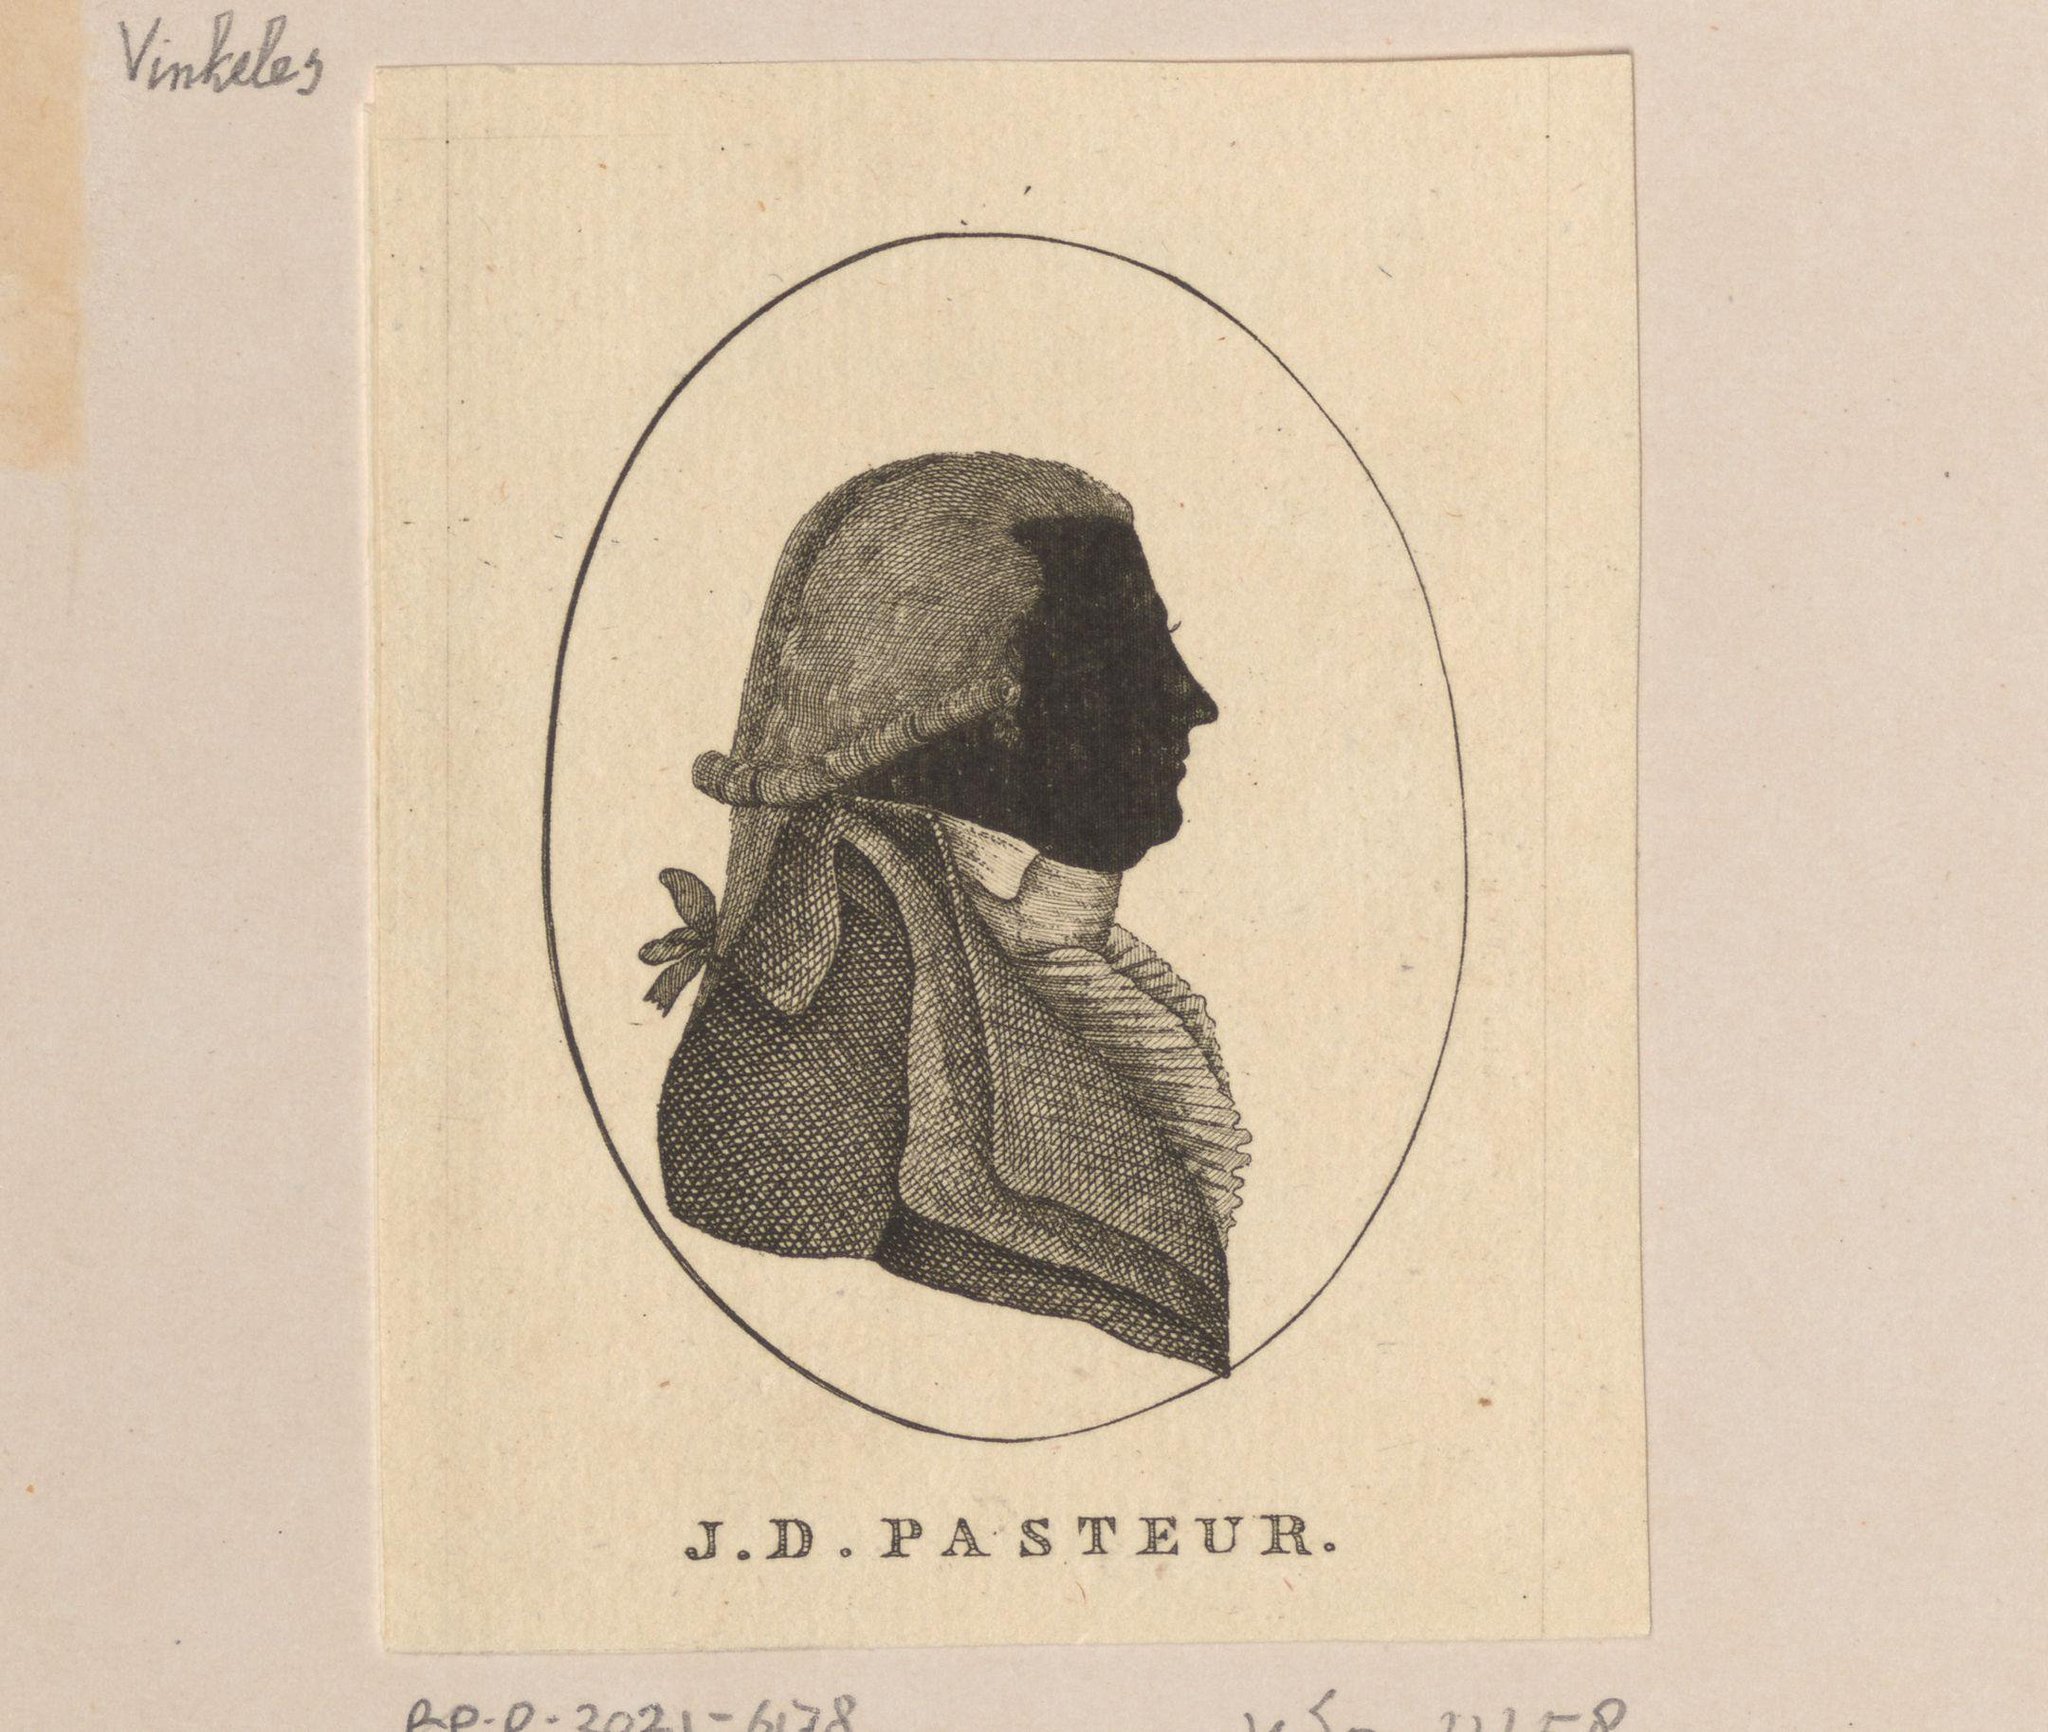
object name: print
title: Portret van Jan David Pasteur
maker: Anonymous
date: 1799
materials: paper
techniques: engraving, etching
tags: leiden, jan david pasteur, adult man, historical persons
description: Prent mogelijk uit: Rogge, Cornelius. Geschiedenis der staatsregeling: voor het Bataafsche volk. Amsterdam: Johannes Allart, 1799.